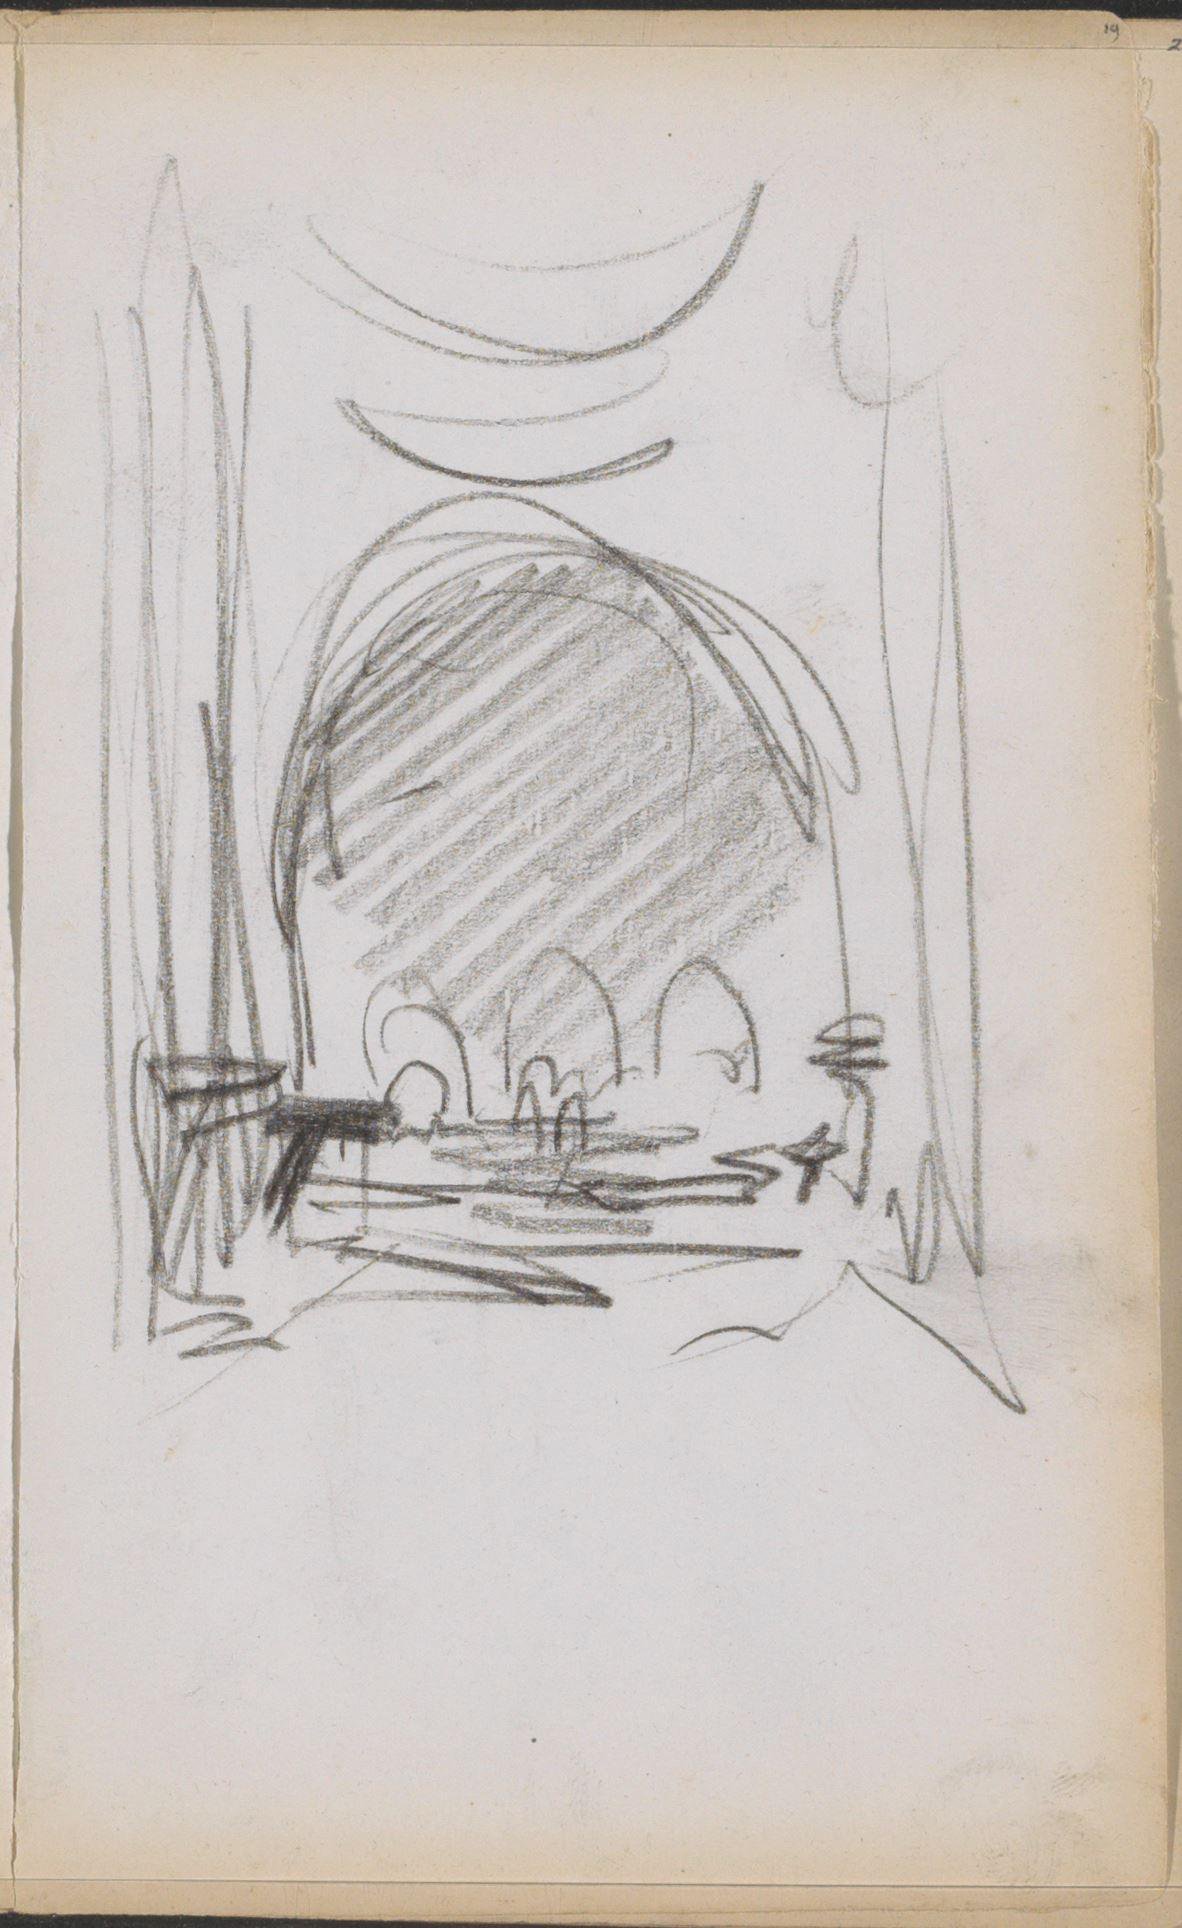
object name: sketchbook leaf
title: Kerkinterieur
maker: marius bauer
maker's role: draughtsman, print maker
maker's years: 1867-1932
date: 1810-1891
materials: chalk, paper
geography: paris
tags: interior of church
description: Pagina 19 uit een schetsboek met 35 bladen.